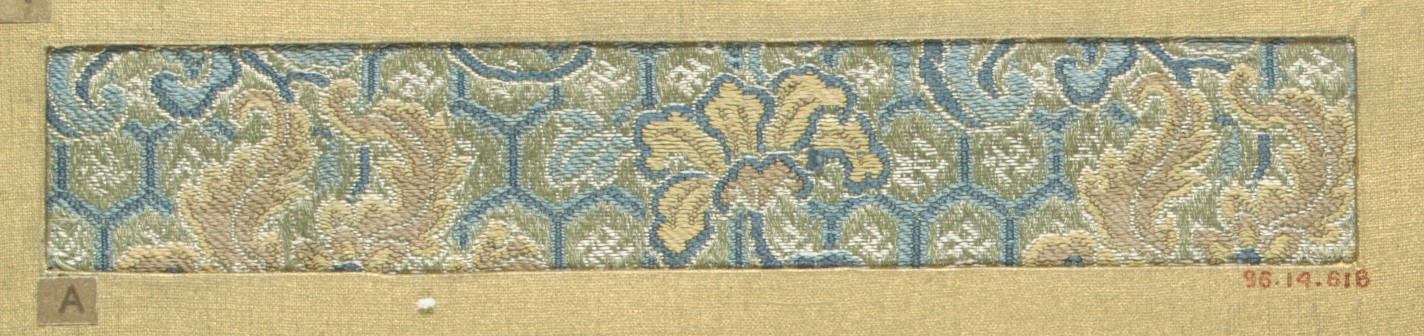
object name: piece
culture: japanese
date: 1701-1900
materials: silk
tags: flowers